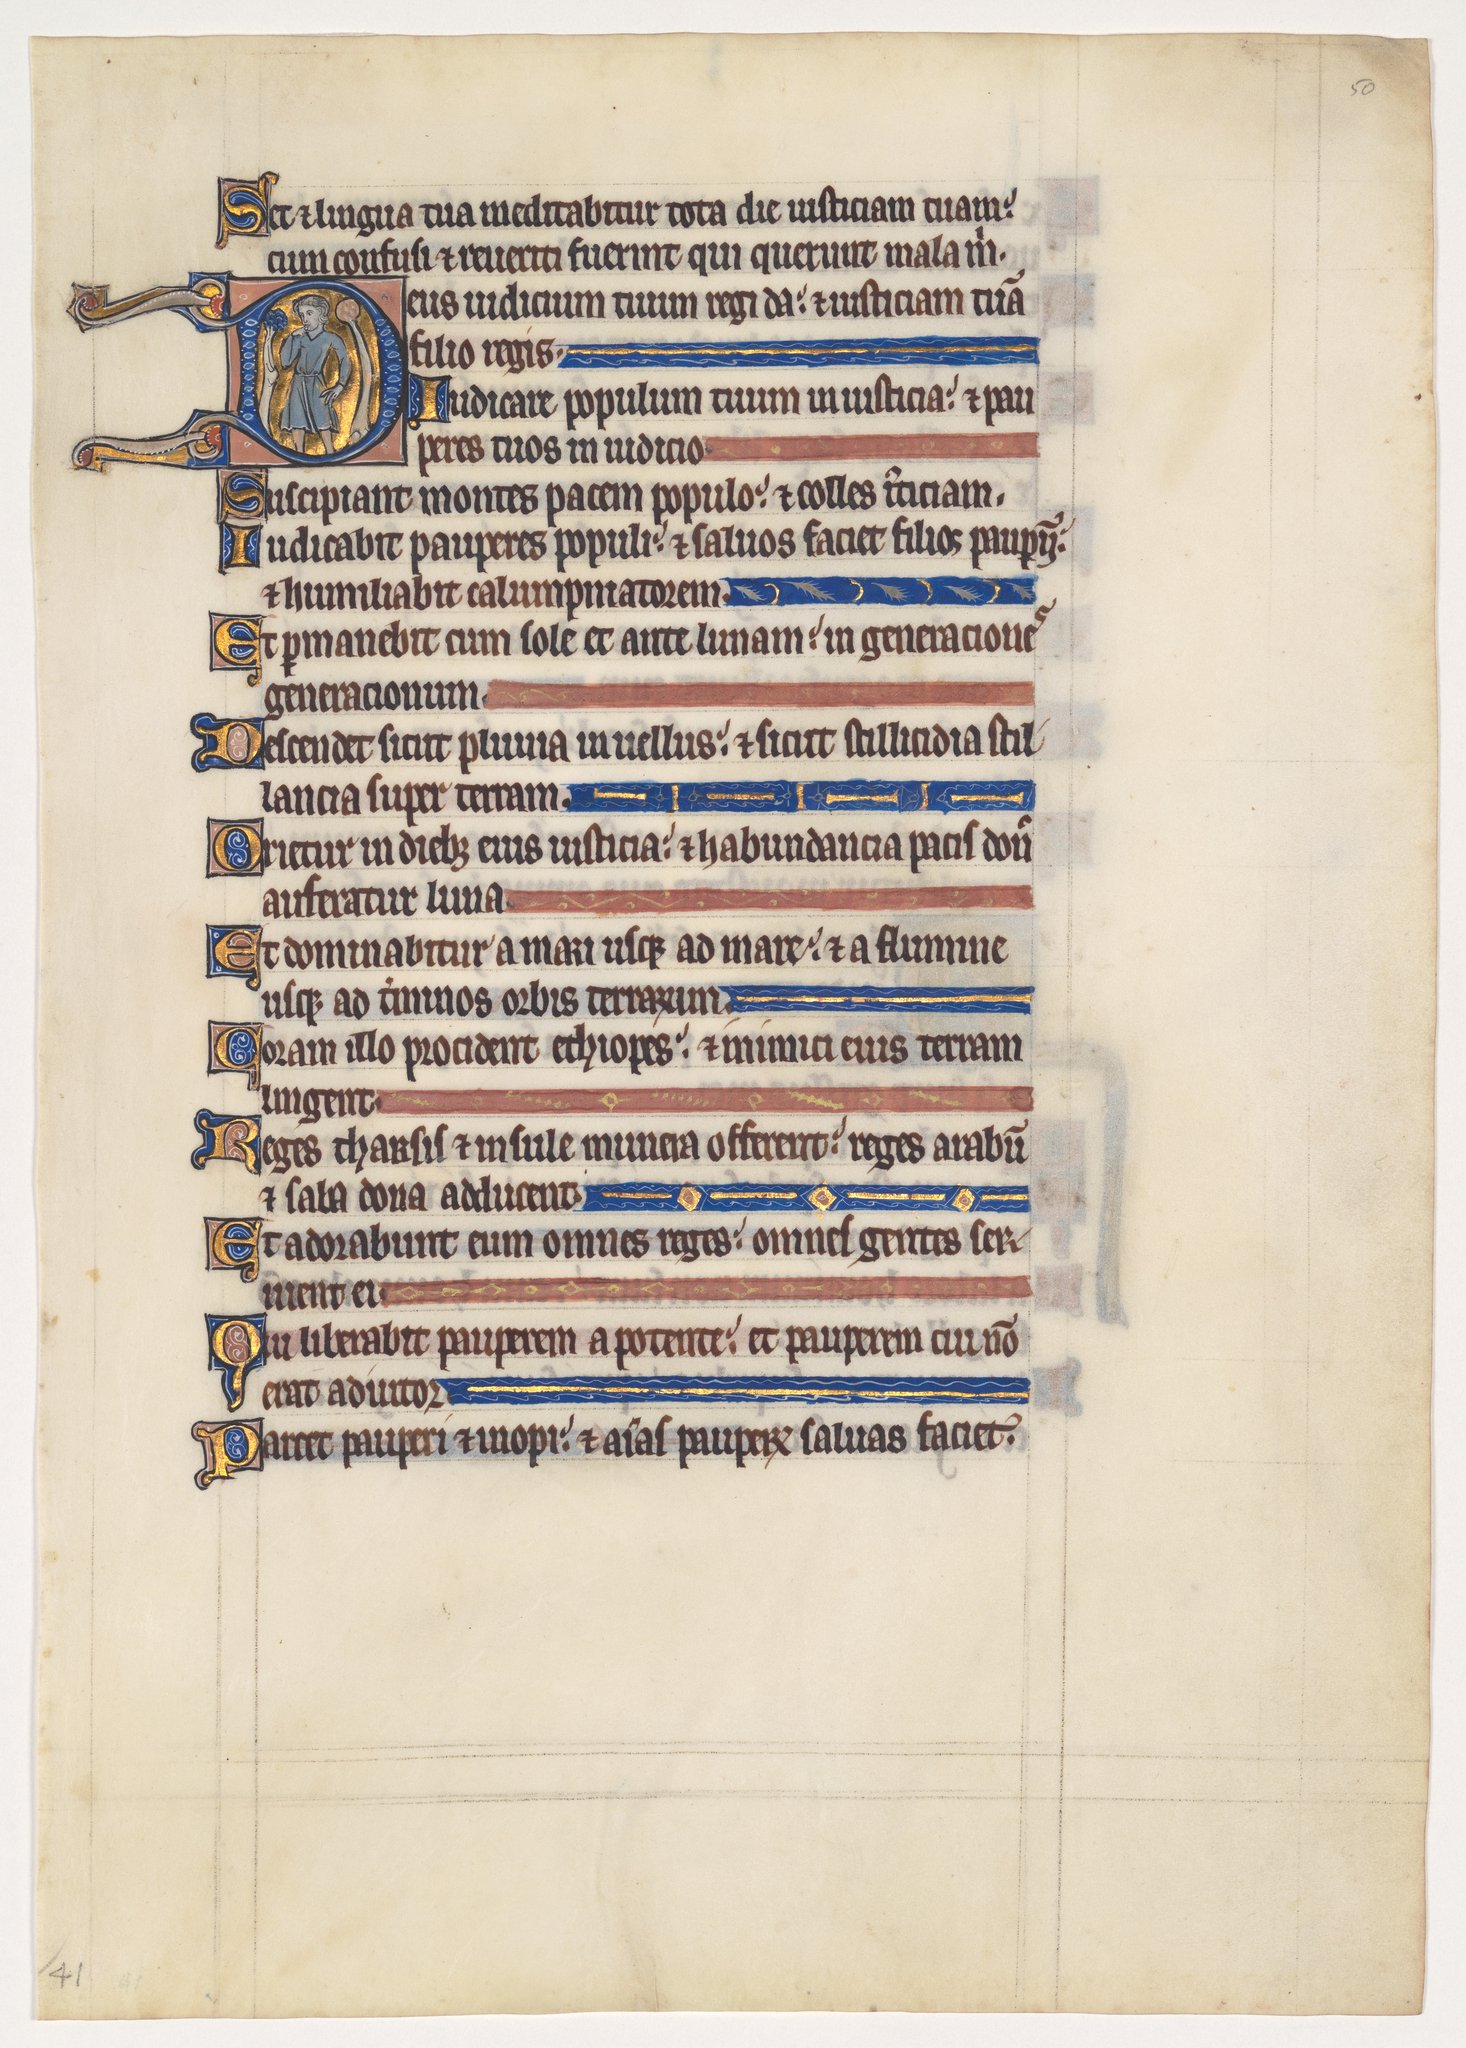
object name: psalter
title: Manuscript Leaf from a Royal Psalter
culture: british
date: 1201-1300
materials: gold, parchment, paint